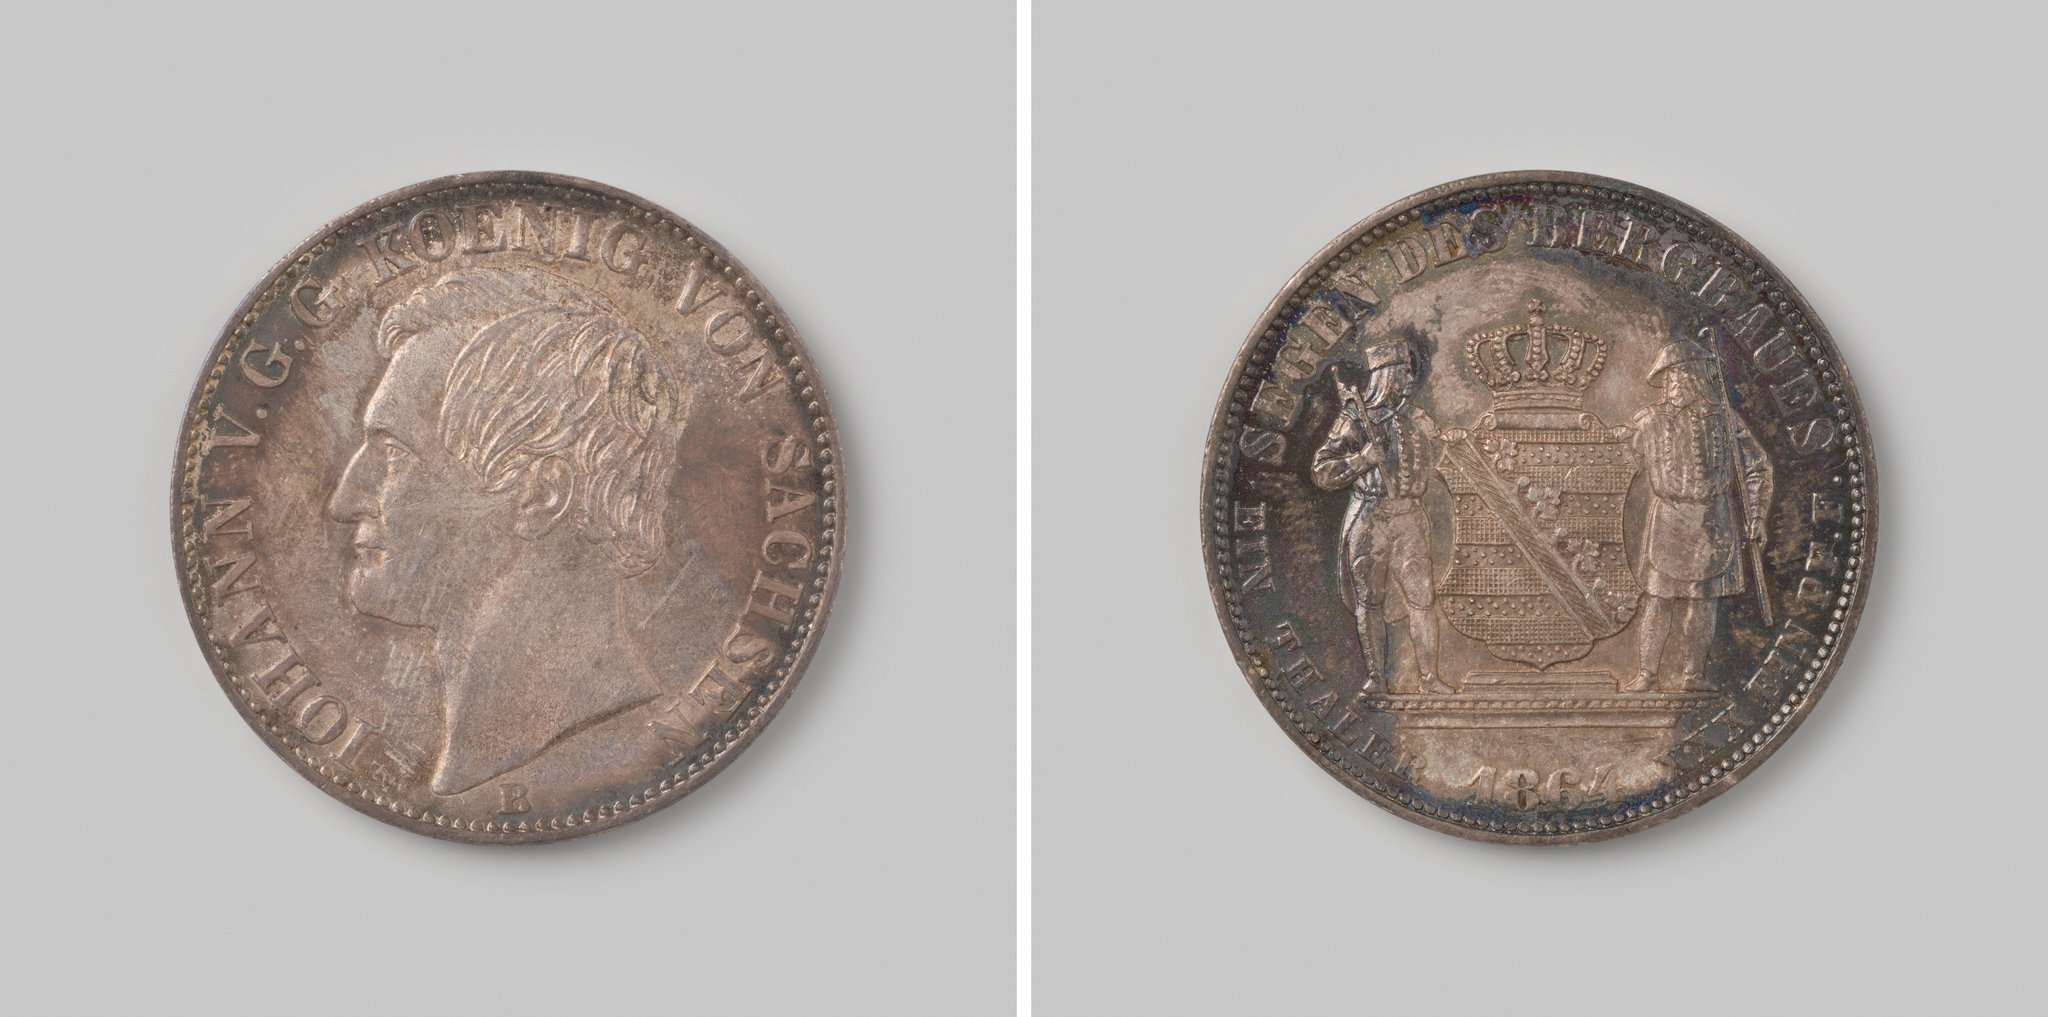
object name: coin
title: Koninkrijk Saksen, Johann, ausbeutetaler,1864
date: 1864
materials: silver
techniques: striking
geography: dresden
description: Zilveren munt. Voorzijde: hoofd van de koning naar links. Onder hoofd letter B. Keerzijde: door twee mijnwerkers als schildhouders gehouden gekroond wapenschild. Daaronder jaartal in omschrift, waarin ook waarde-aanduiding. Randschrift.